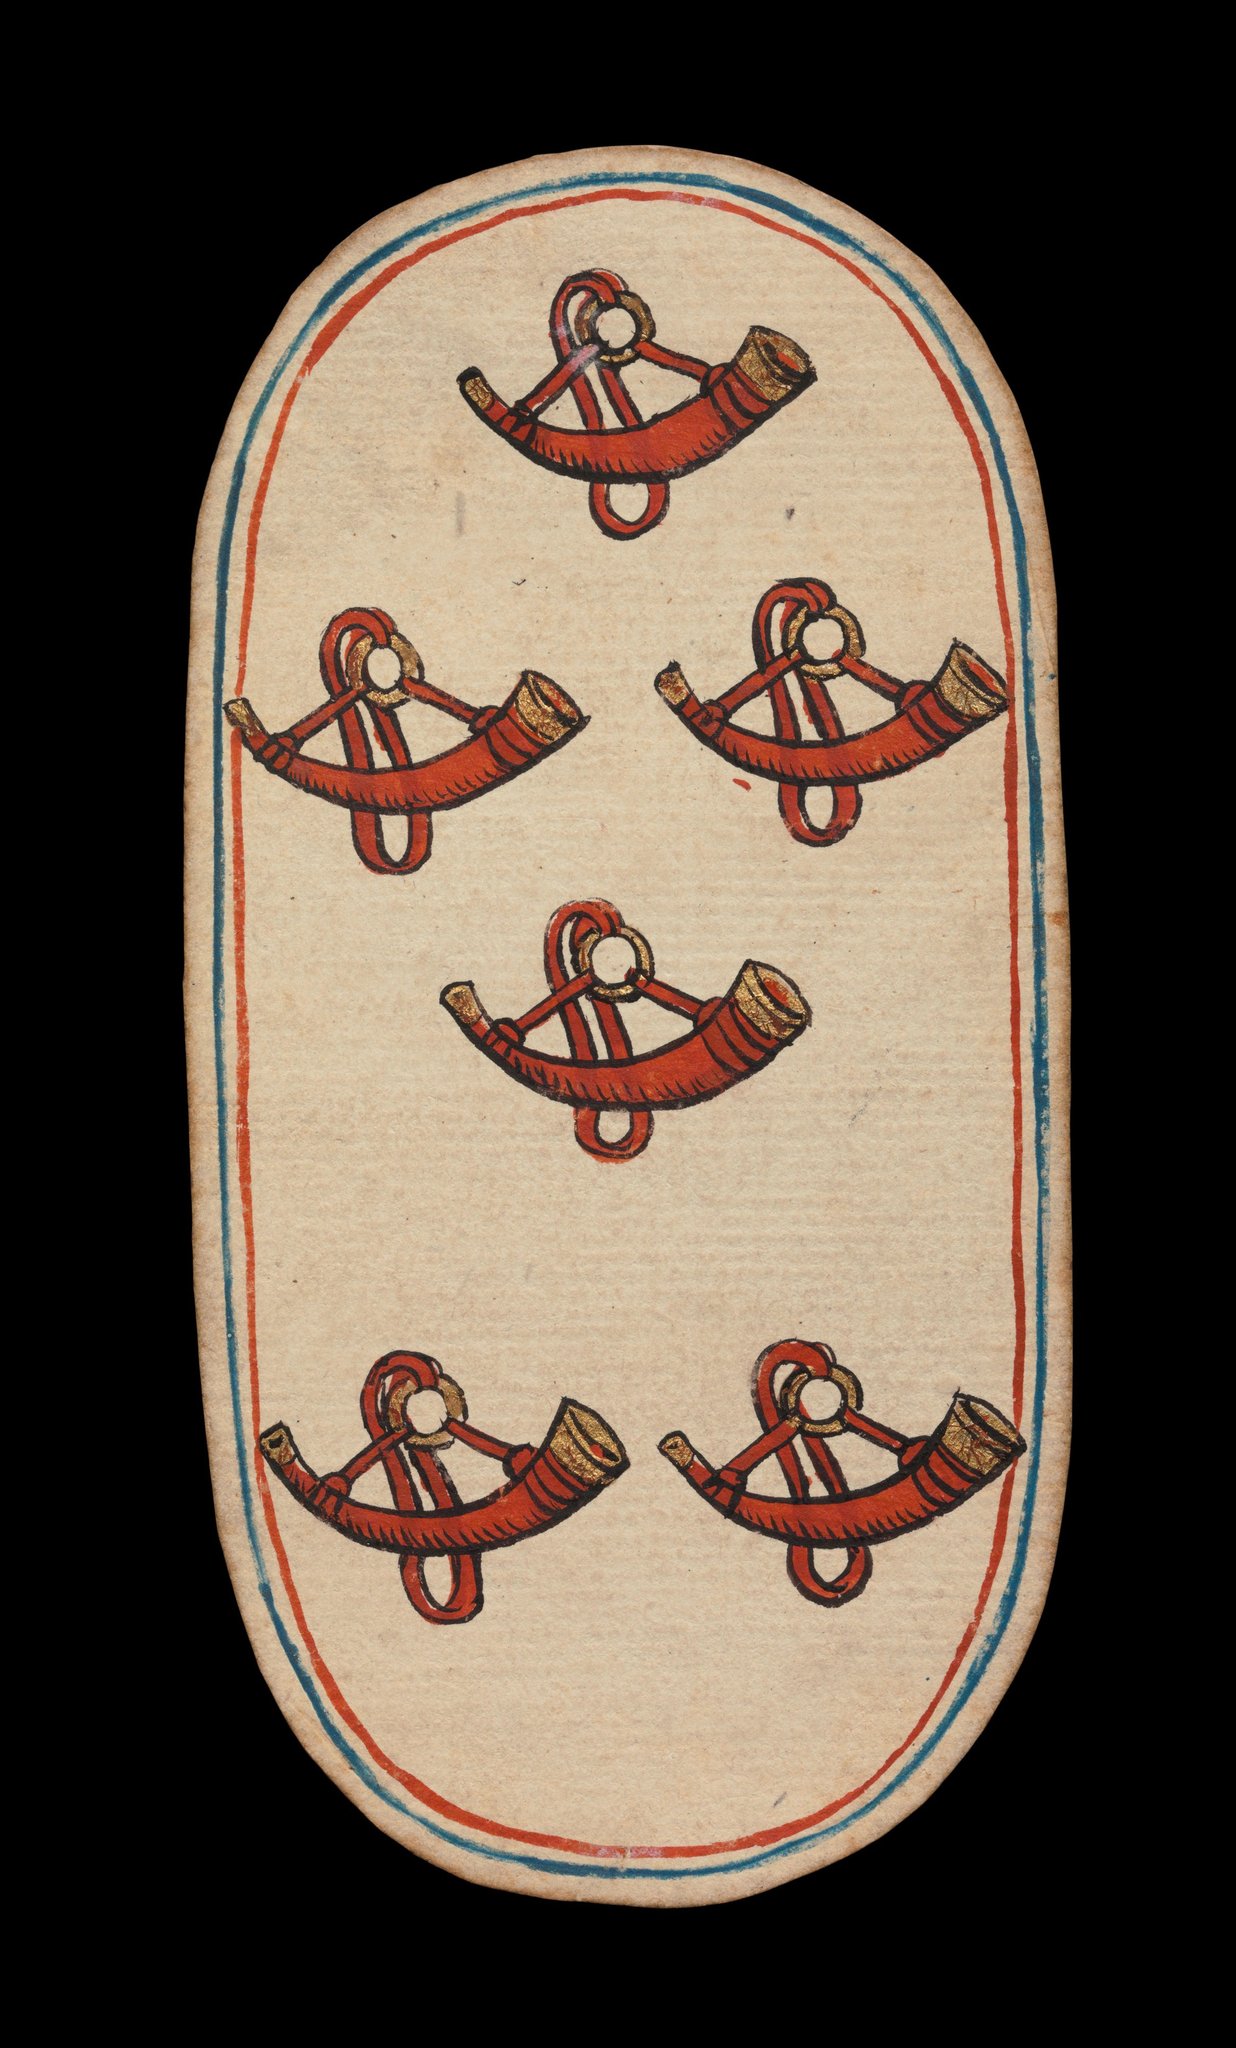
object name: playing card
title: 6 of Horns, from The Cloisters Playing Cards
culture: south netherlandish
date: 1475-1480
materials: glaze, gold, ink, paint, paper, silver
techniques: pen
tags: playing cards,horns,games